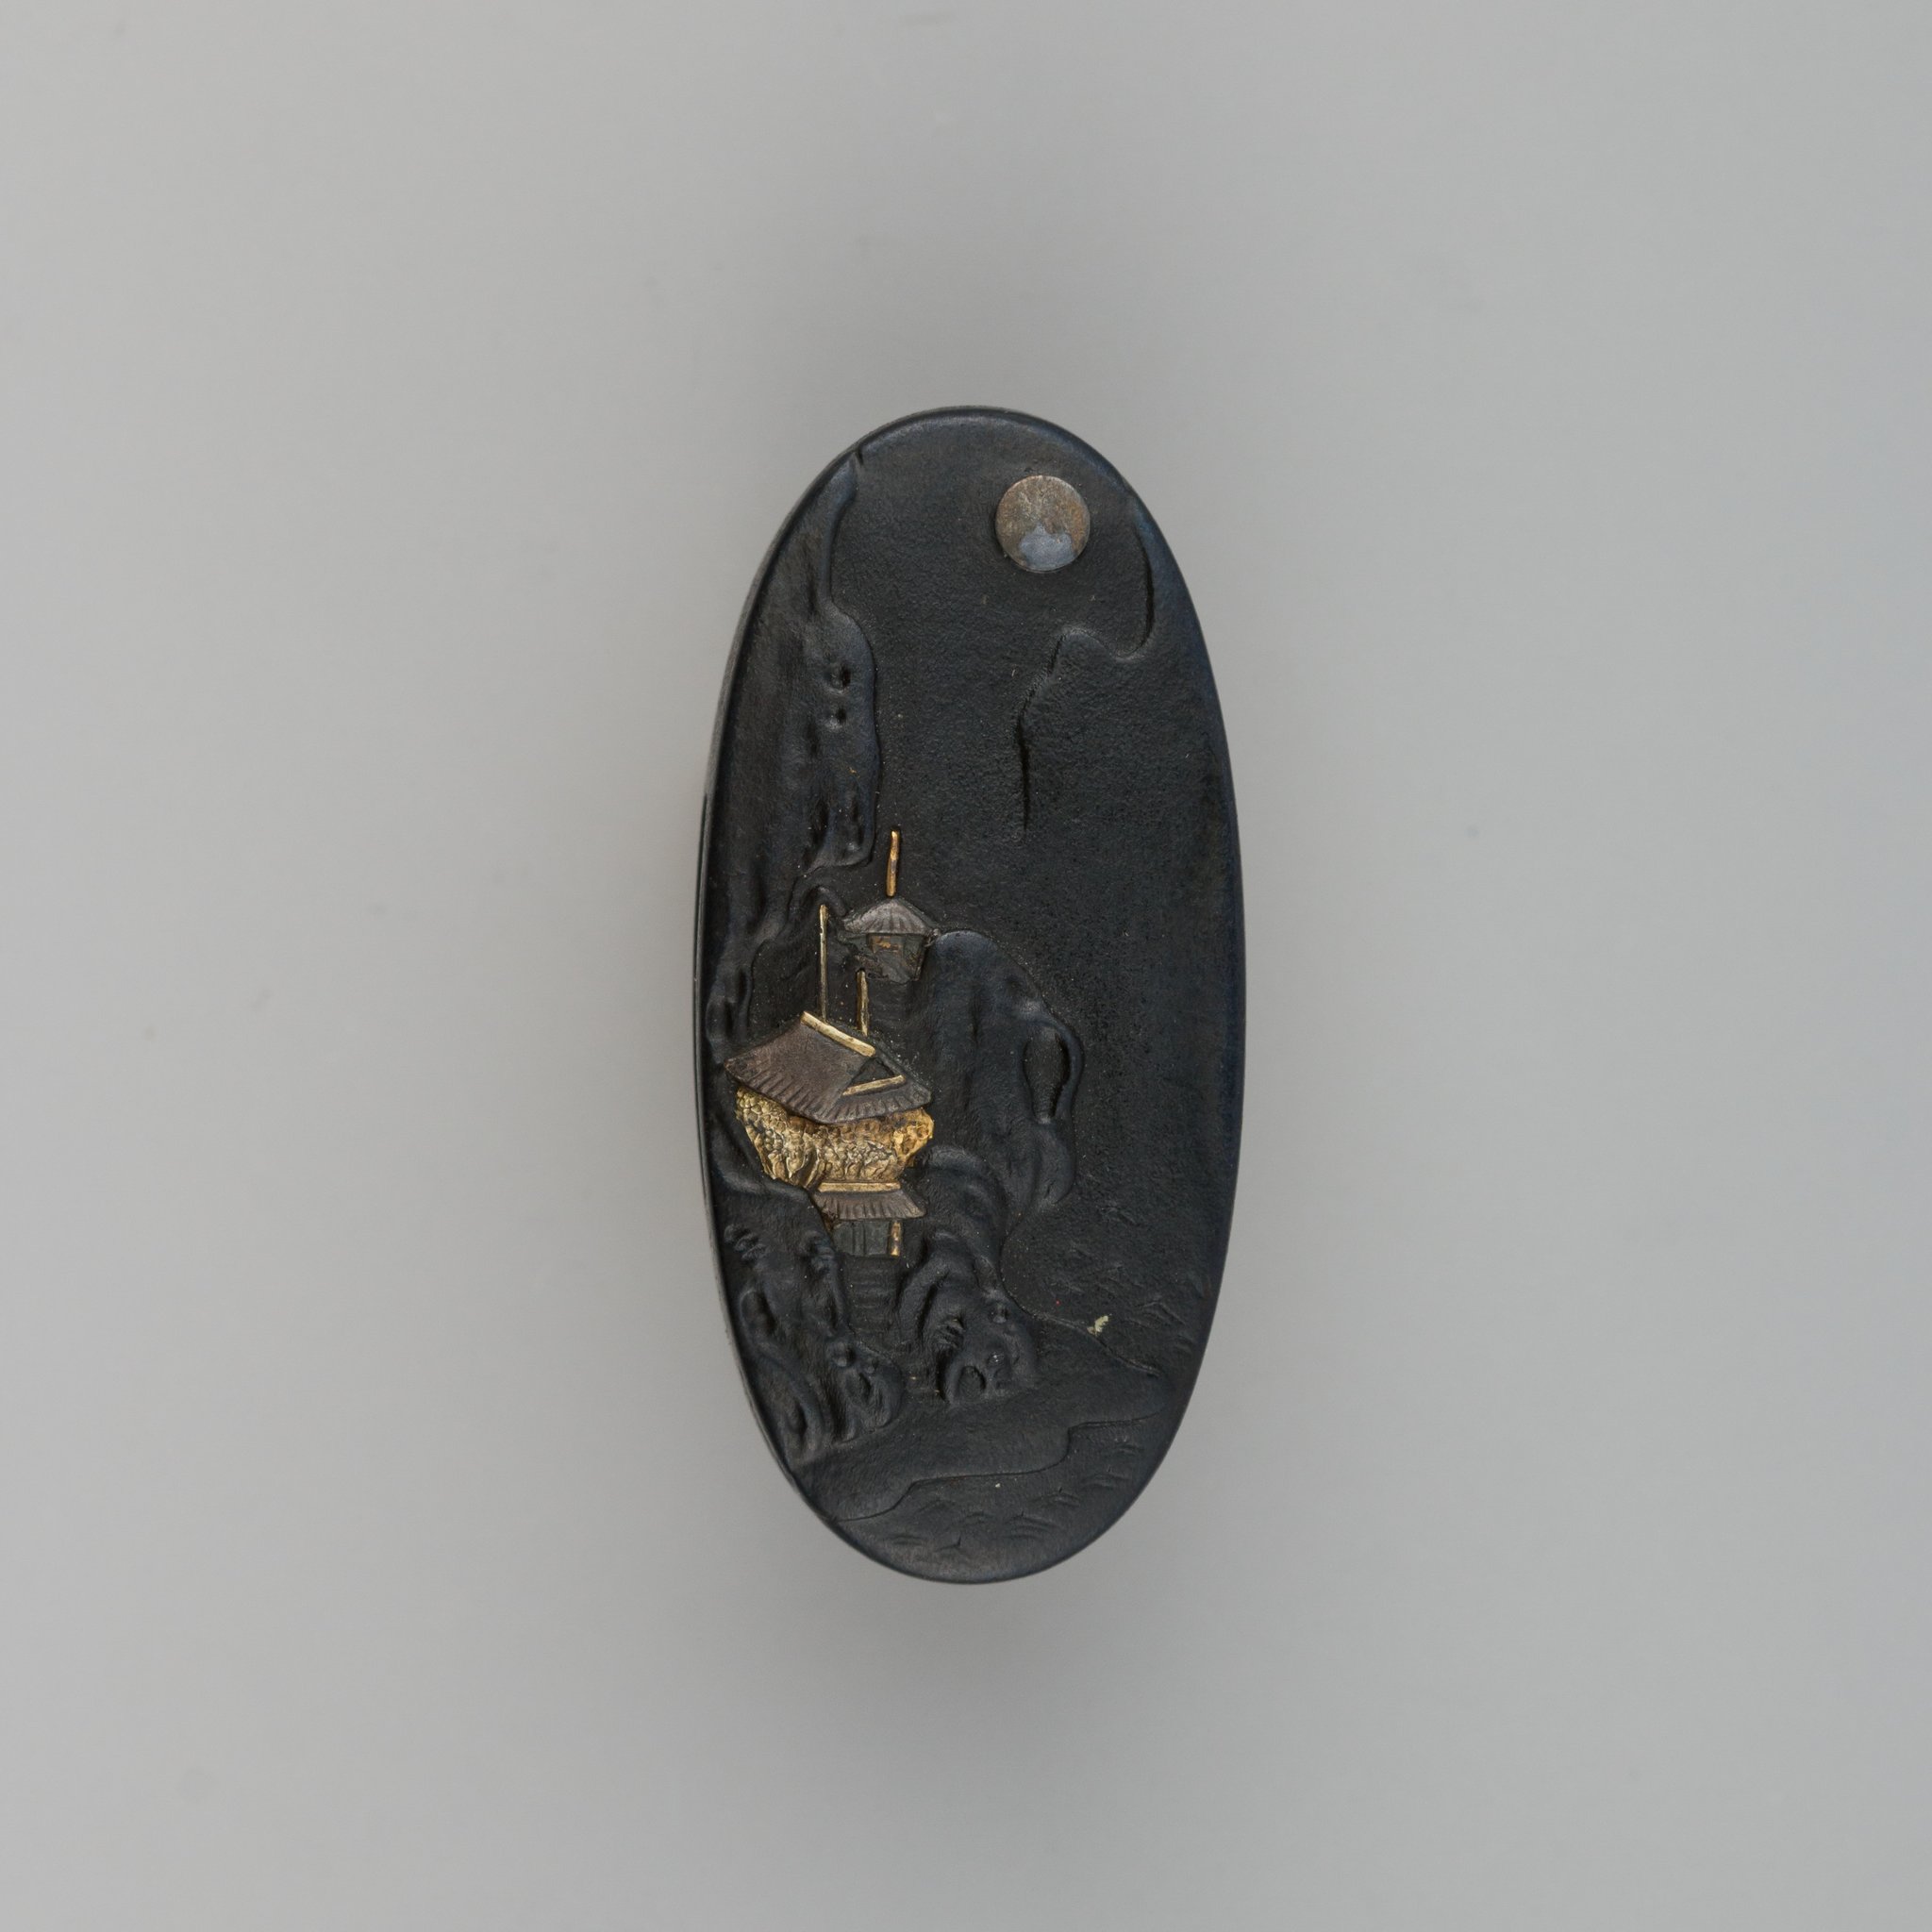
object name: sword pommel kashira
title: Sword Pommel (Kashira)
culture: japanese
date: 1615-1868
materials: gold alloy, gold, silver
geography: japan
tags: houses